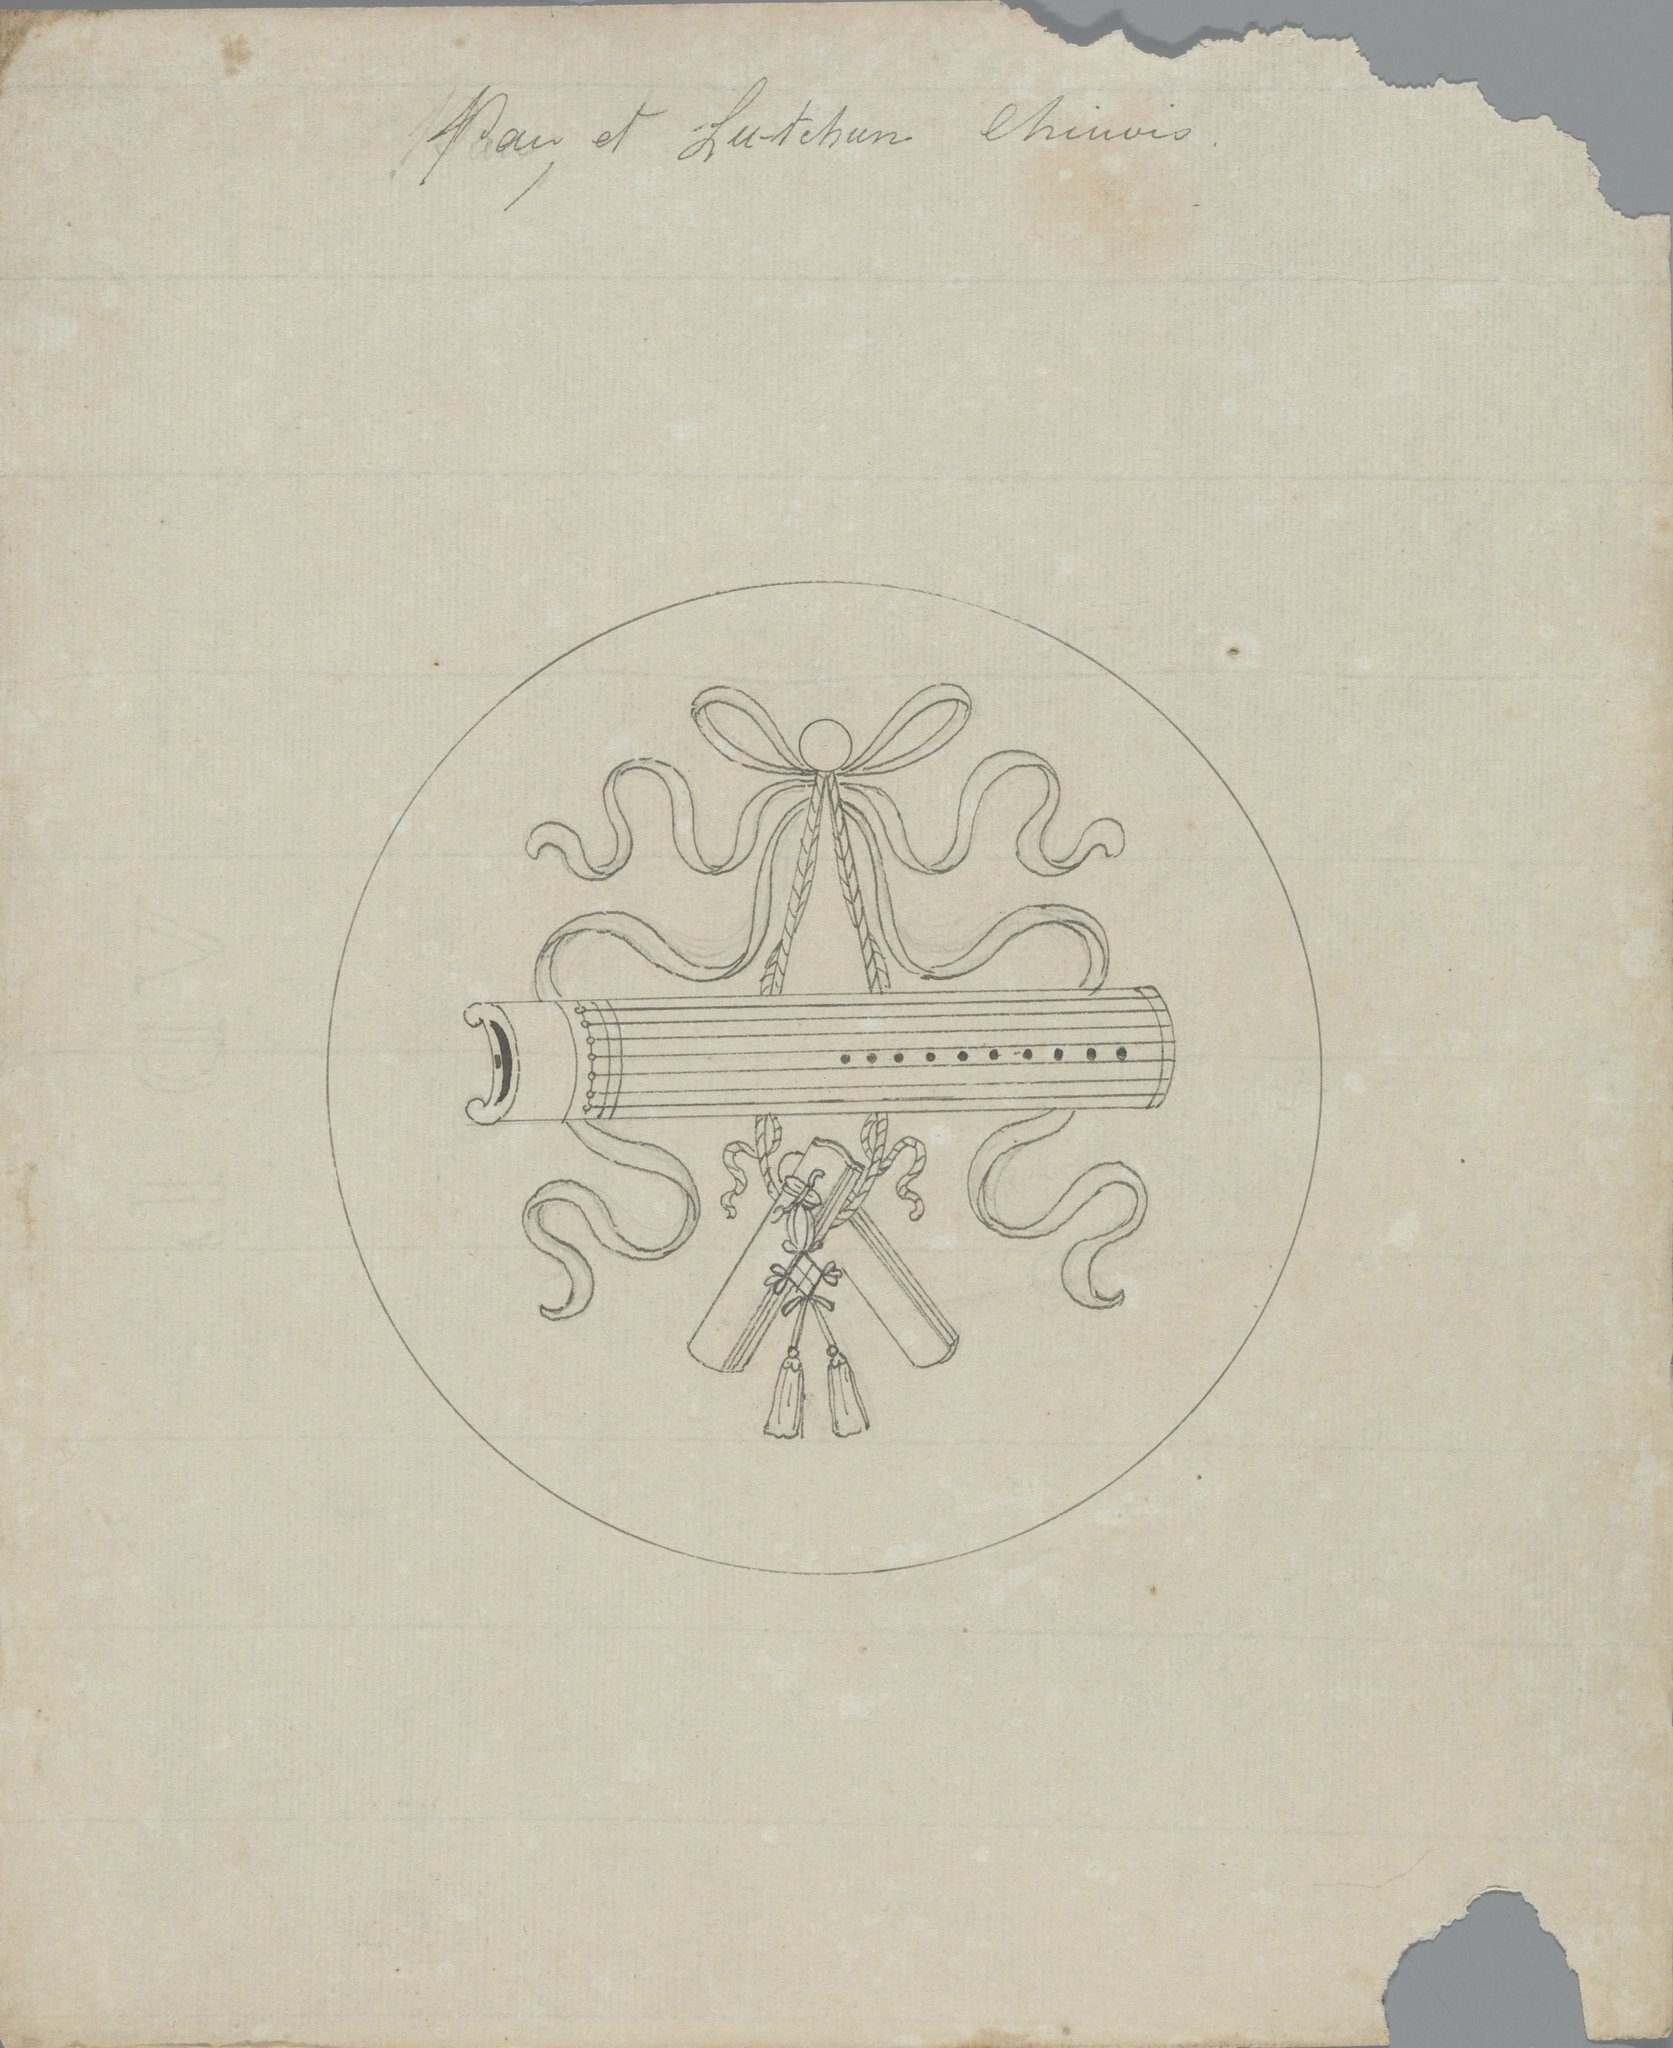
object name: design drawing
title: Pan et Lutchun Chinois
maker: pierre félix van doren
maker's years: 1797-1856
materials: graphite, ink, paper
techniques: pen in black ink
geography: brussels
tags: trophy, i.e.: decorative arrangement of symbolic or typical objects ~ ornament, flute, aulos, tibia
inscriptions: watermark: ‘VDL’, inscription: ‘Pan et Lutchun Chinois’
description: Een van 103 ontwerpen voor marqueterie van aan linten opgehangen muziekinstrumenten in ronde medaillons, bestemd voor de set stoelen gemaakt door Van Doren voor de grote zaal van het Paleis van de Prins van Oranje in Brussel in 1828.